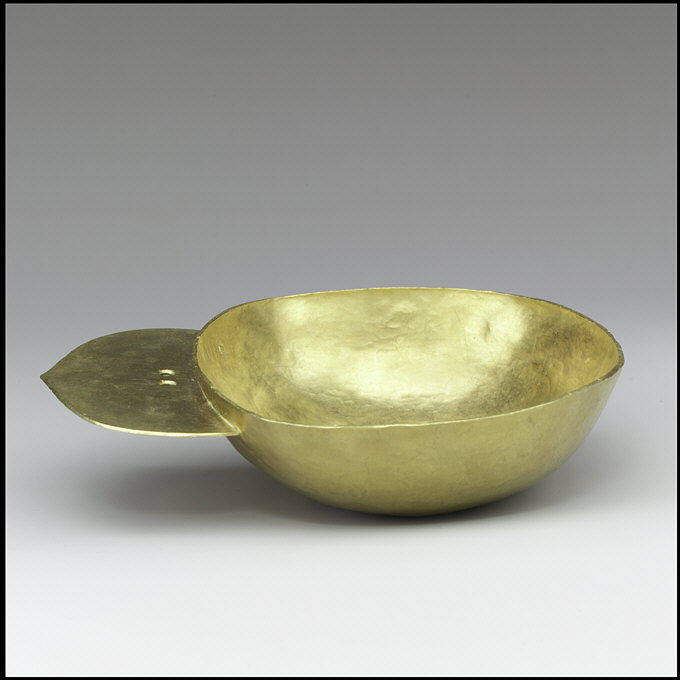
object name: bowl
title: Gold Drinking Bowl with Handle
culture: avar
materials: gold